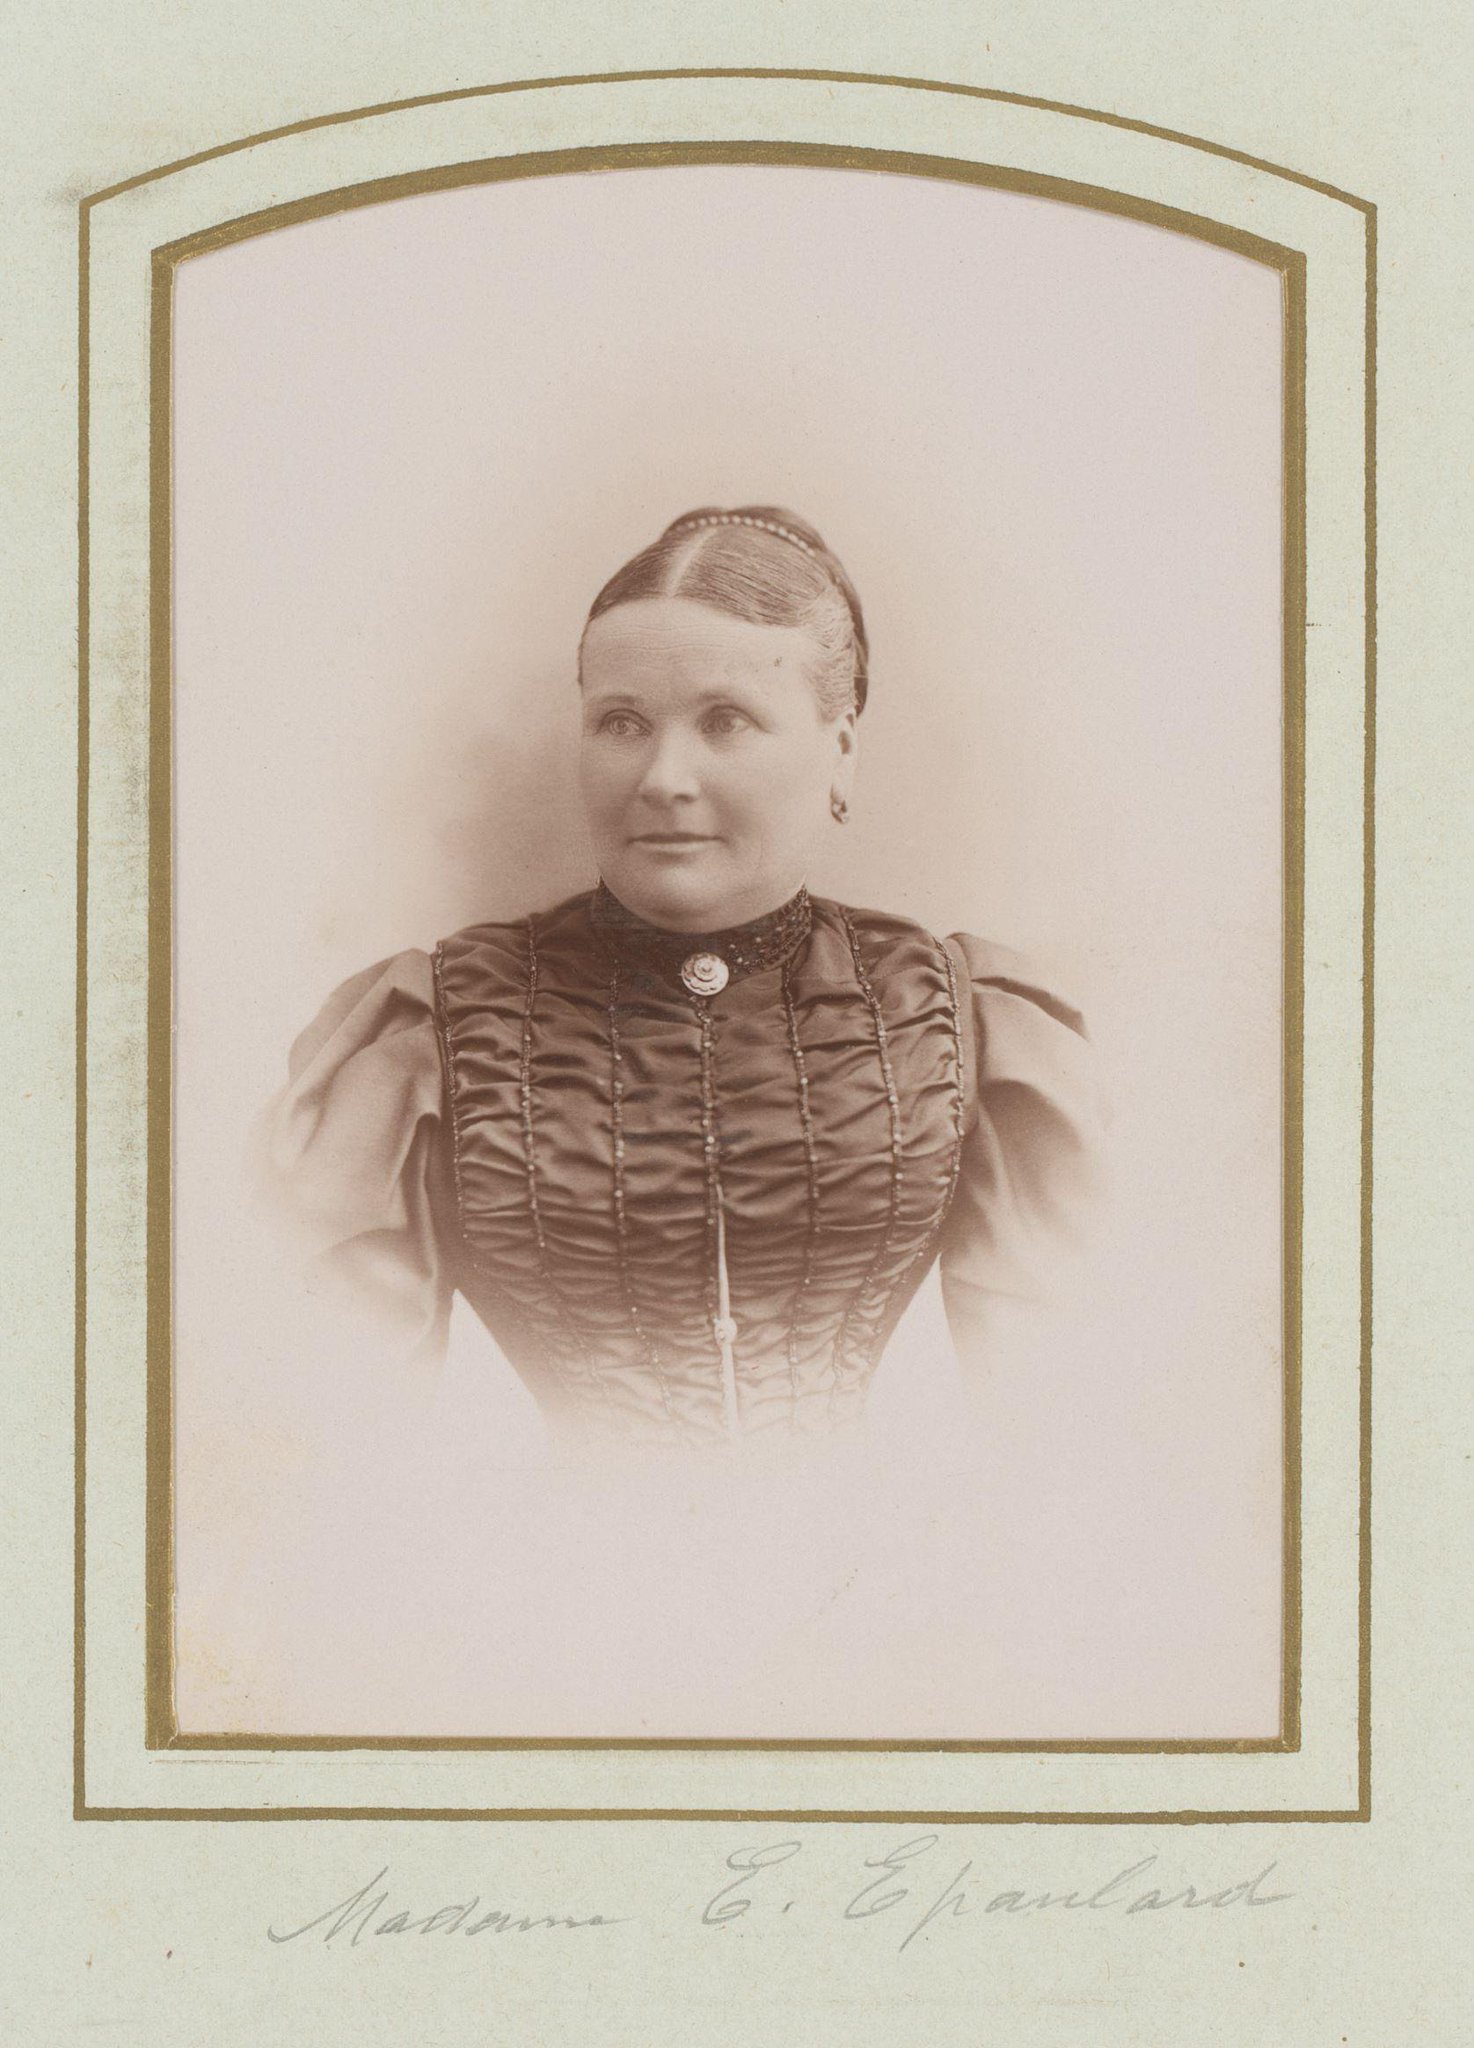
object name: album leaf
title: Portret van de vrouw van Edouard Epaulard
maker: victor daireaux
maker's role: publisher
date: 1889-1900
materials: cardboard, photographic support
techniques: albumen print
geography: paris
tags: historical persons - bb - woman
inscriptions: name: ‘Madame E. Epaulard’, inscription: ‘Photographie/ V. Daireaux/ 156& 158, Rue de Rivoli,/ MÉDAILLÉ/ a/ l'Exposition Universelle/ 1889/ Ateliers/ 10, Rue Bailleul, 10/ Paris/ Les Clichés sont conservés No.’